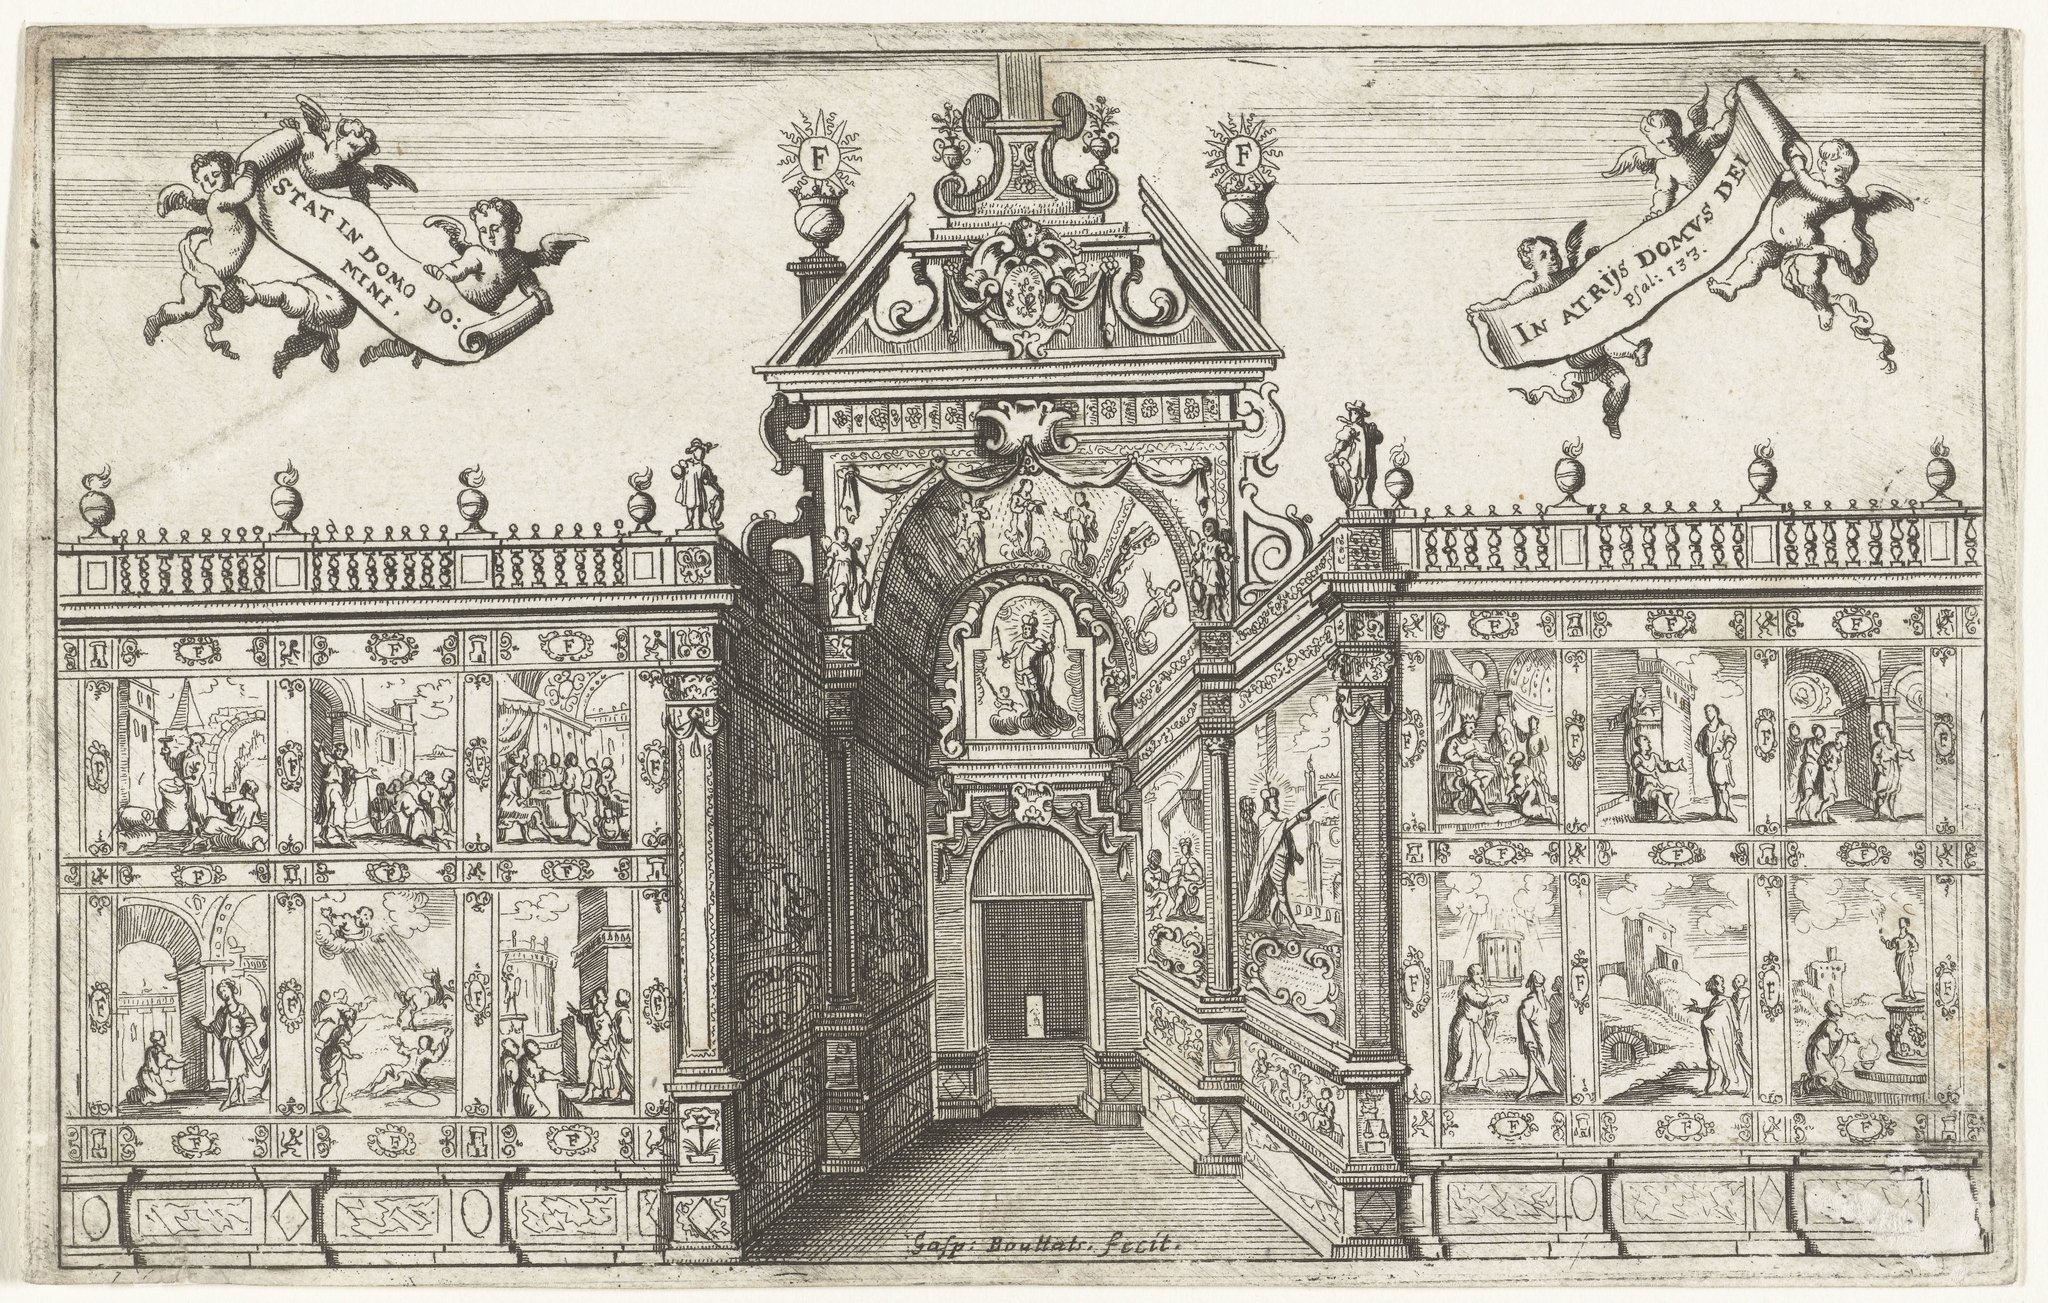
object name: print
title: Ceremoniële ingang voor een kerk, 1685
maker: gaspar bouttats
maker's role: print maker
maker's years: 1640-1695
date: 1685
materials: paper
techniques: etching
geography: southern netherlands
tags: other decorative structures (~ triumphal entry, etc.), antwerp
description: Gebruikt als illustratie in: Hondert-jaerigh jubile-vreught bewesen in dese stadt Antwerpen ter oorsaecke vande herstellinge des geloofs in't jaer 1585. door de glorieuse waepenen van sijne catholijcke majesteyt, onder t'beleyt van ... Alexander Farnesius ... / Ghemaeckt ende by-een vergadert door ... Petrus Franciscus de Smidt, Hieronymus Verdussen den jonghere, Antwerpen 1685.